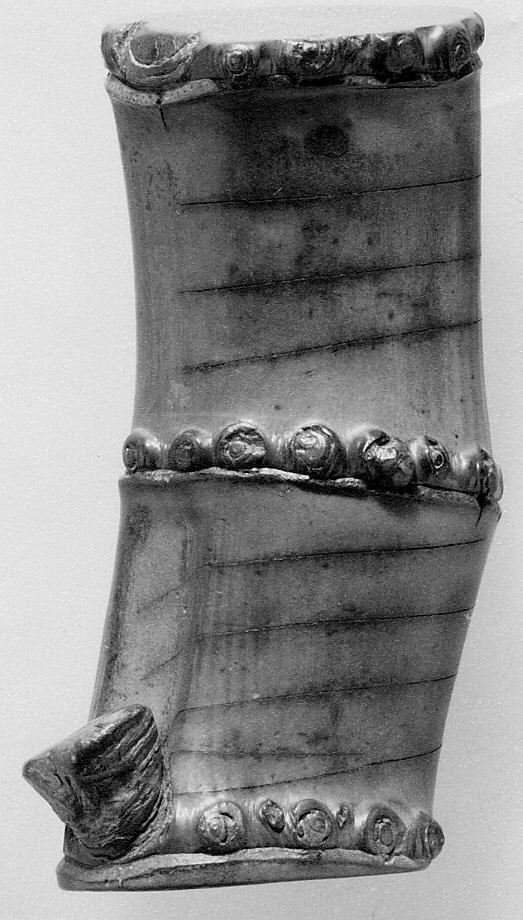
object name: seal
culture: chinese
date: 1736-1795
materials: bamboo